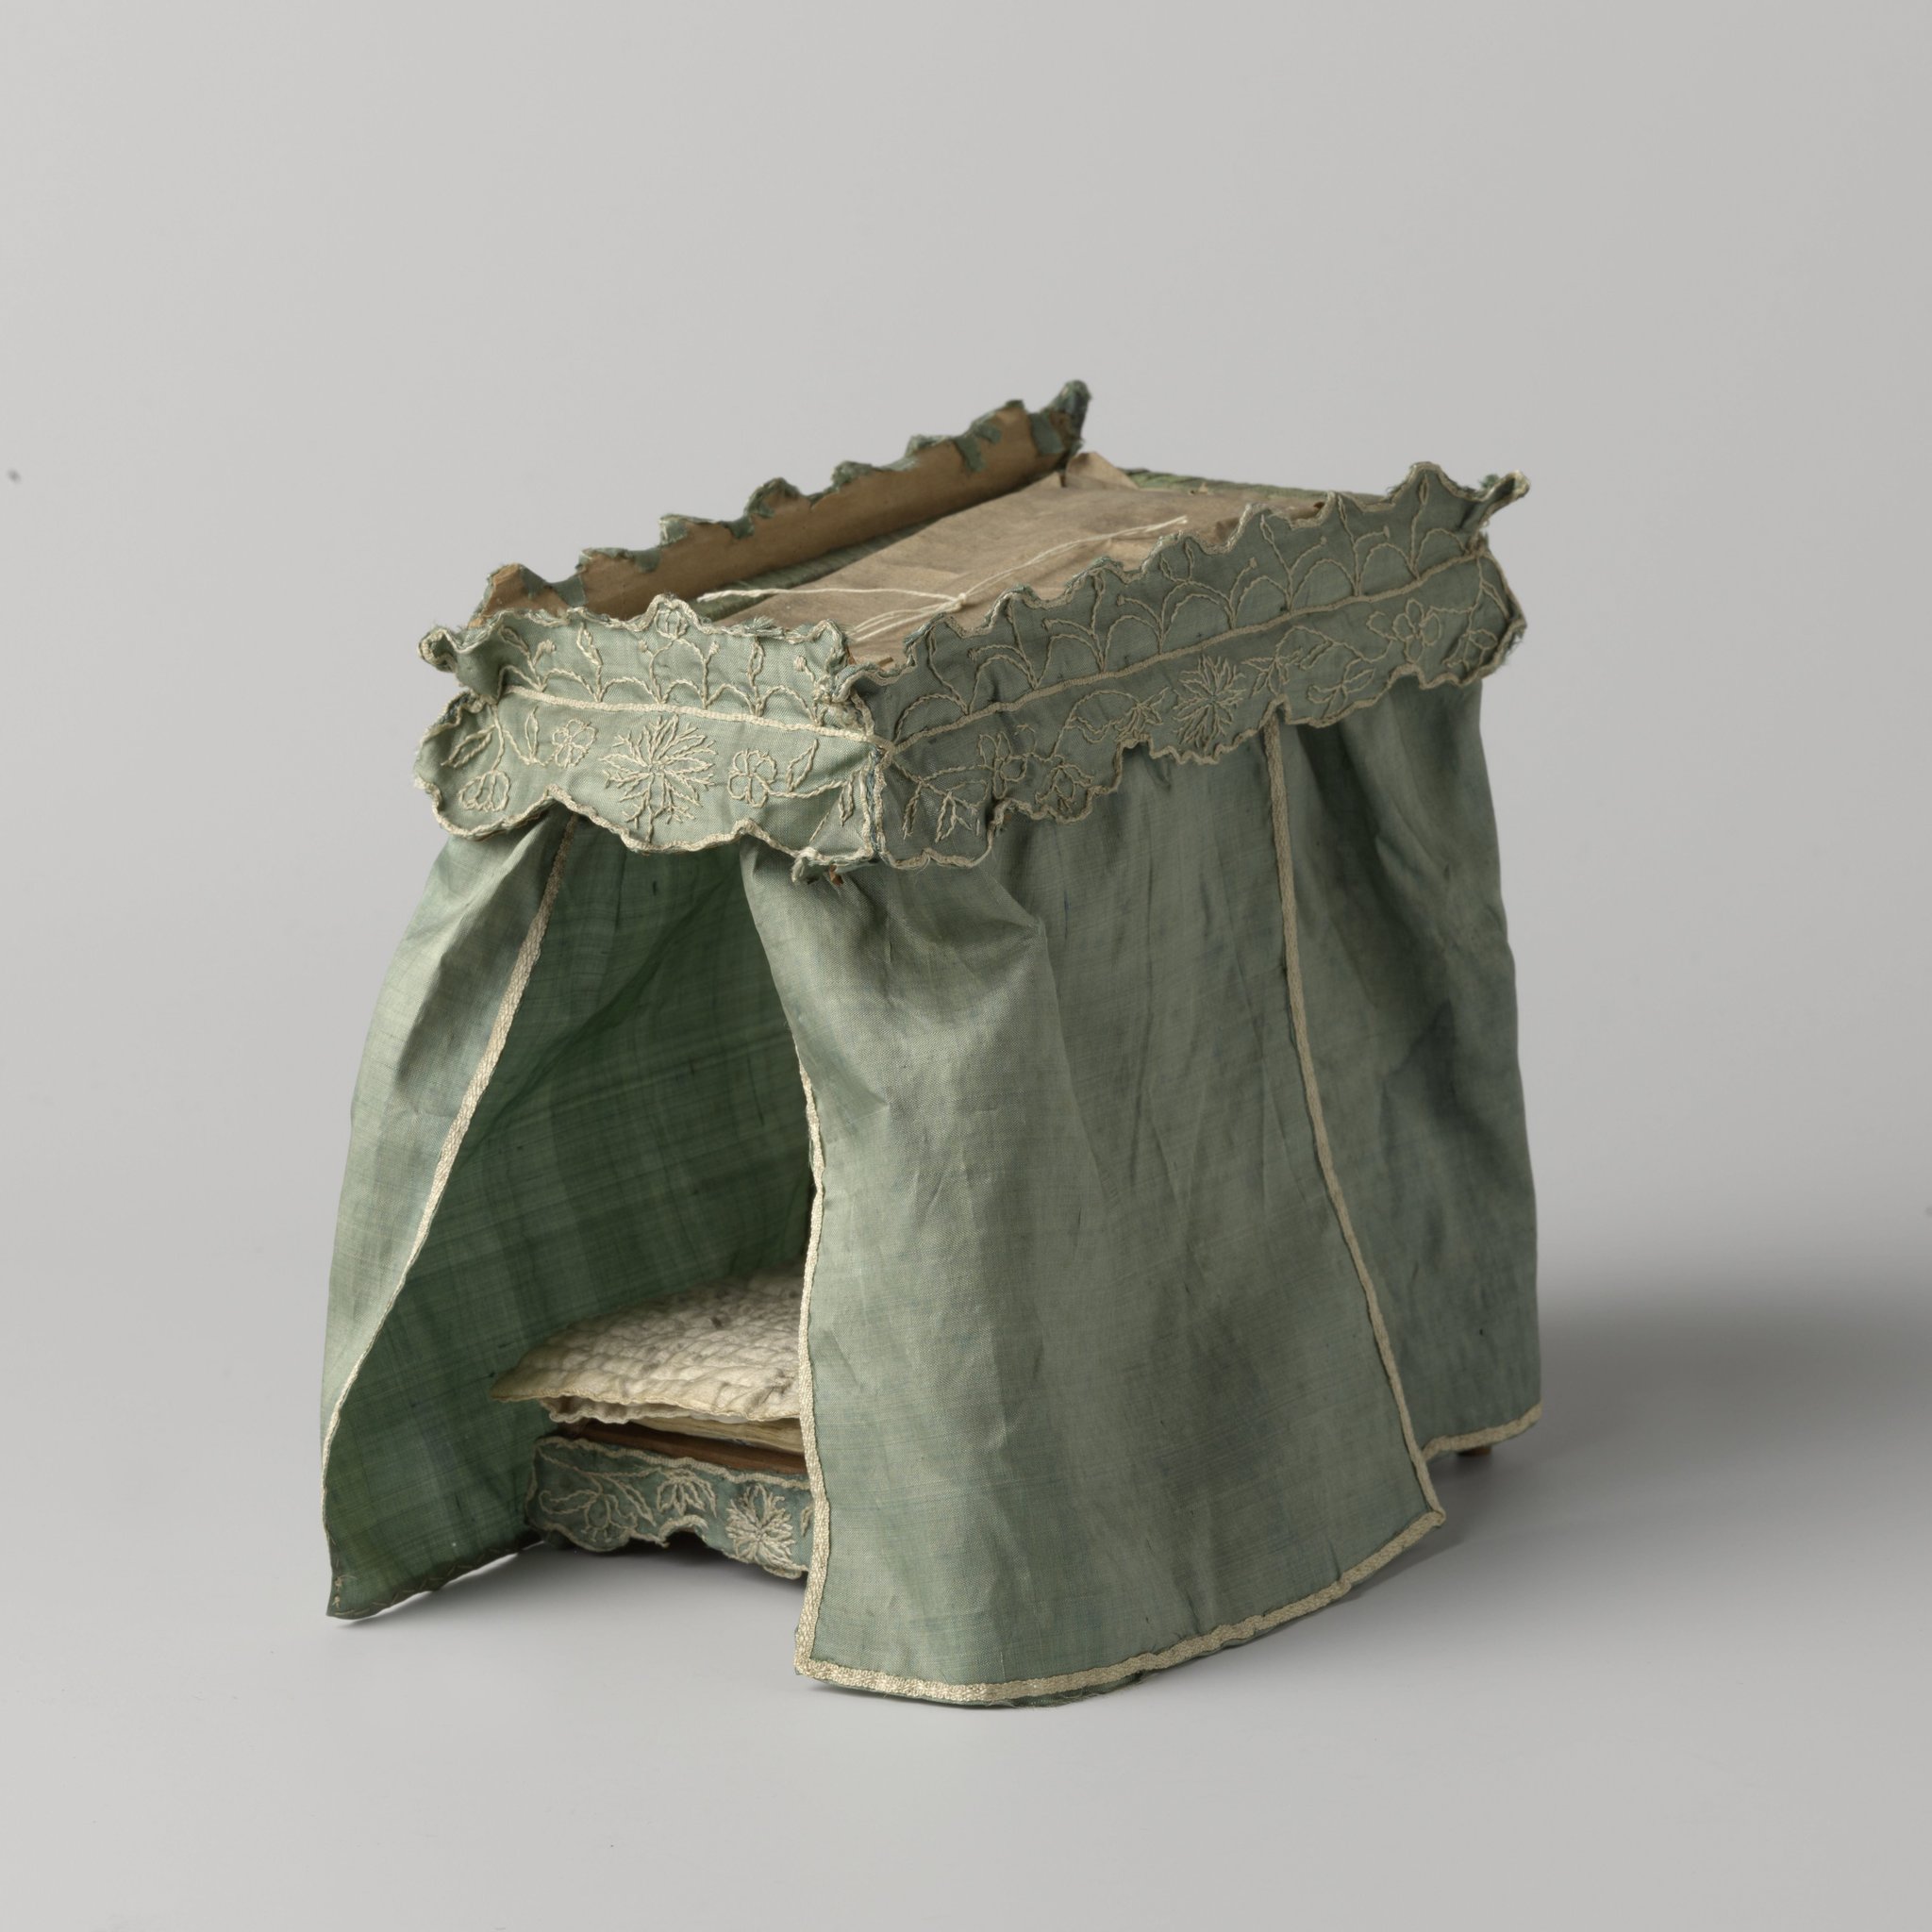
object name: bedspread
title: Helft van een sprei, ivoorkleurig, doorgestikt in schelpmotief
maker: Anonymous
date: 1750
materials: silk, wool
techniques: napping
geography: amsterdam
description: Helft van een sprei van ivoorkleurige zijdesatijn, gevuld met een tussenlaag van (geruwde) wol; doorgestikt met lichte zijden draad in schelpmotief in het midden en in de hoeken.